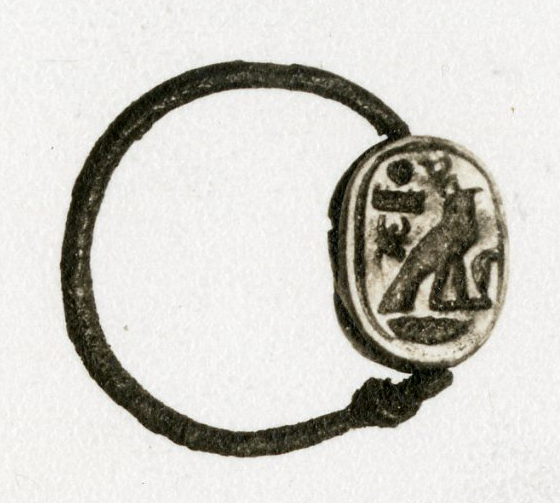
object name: ring, thutmose iii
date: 1479-1425 BCE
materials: bronze, copper alloy, stone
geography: egypt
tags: hieroglyphs